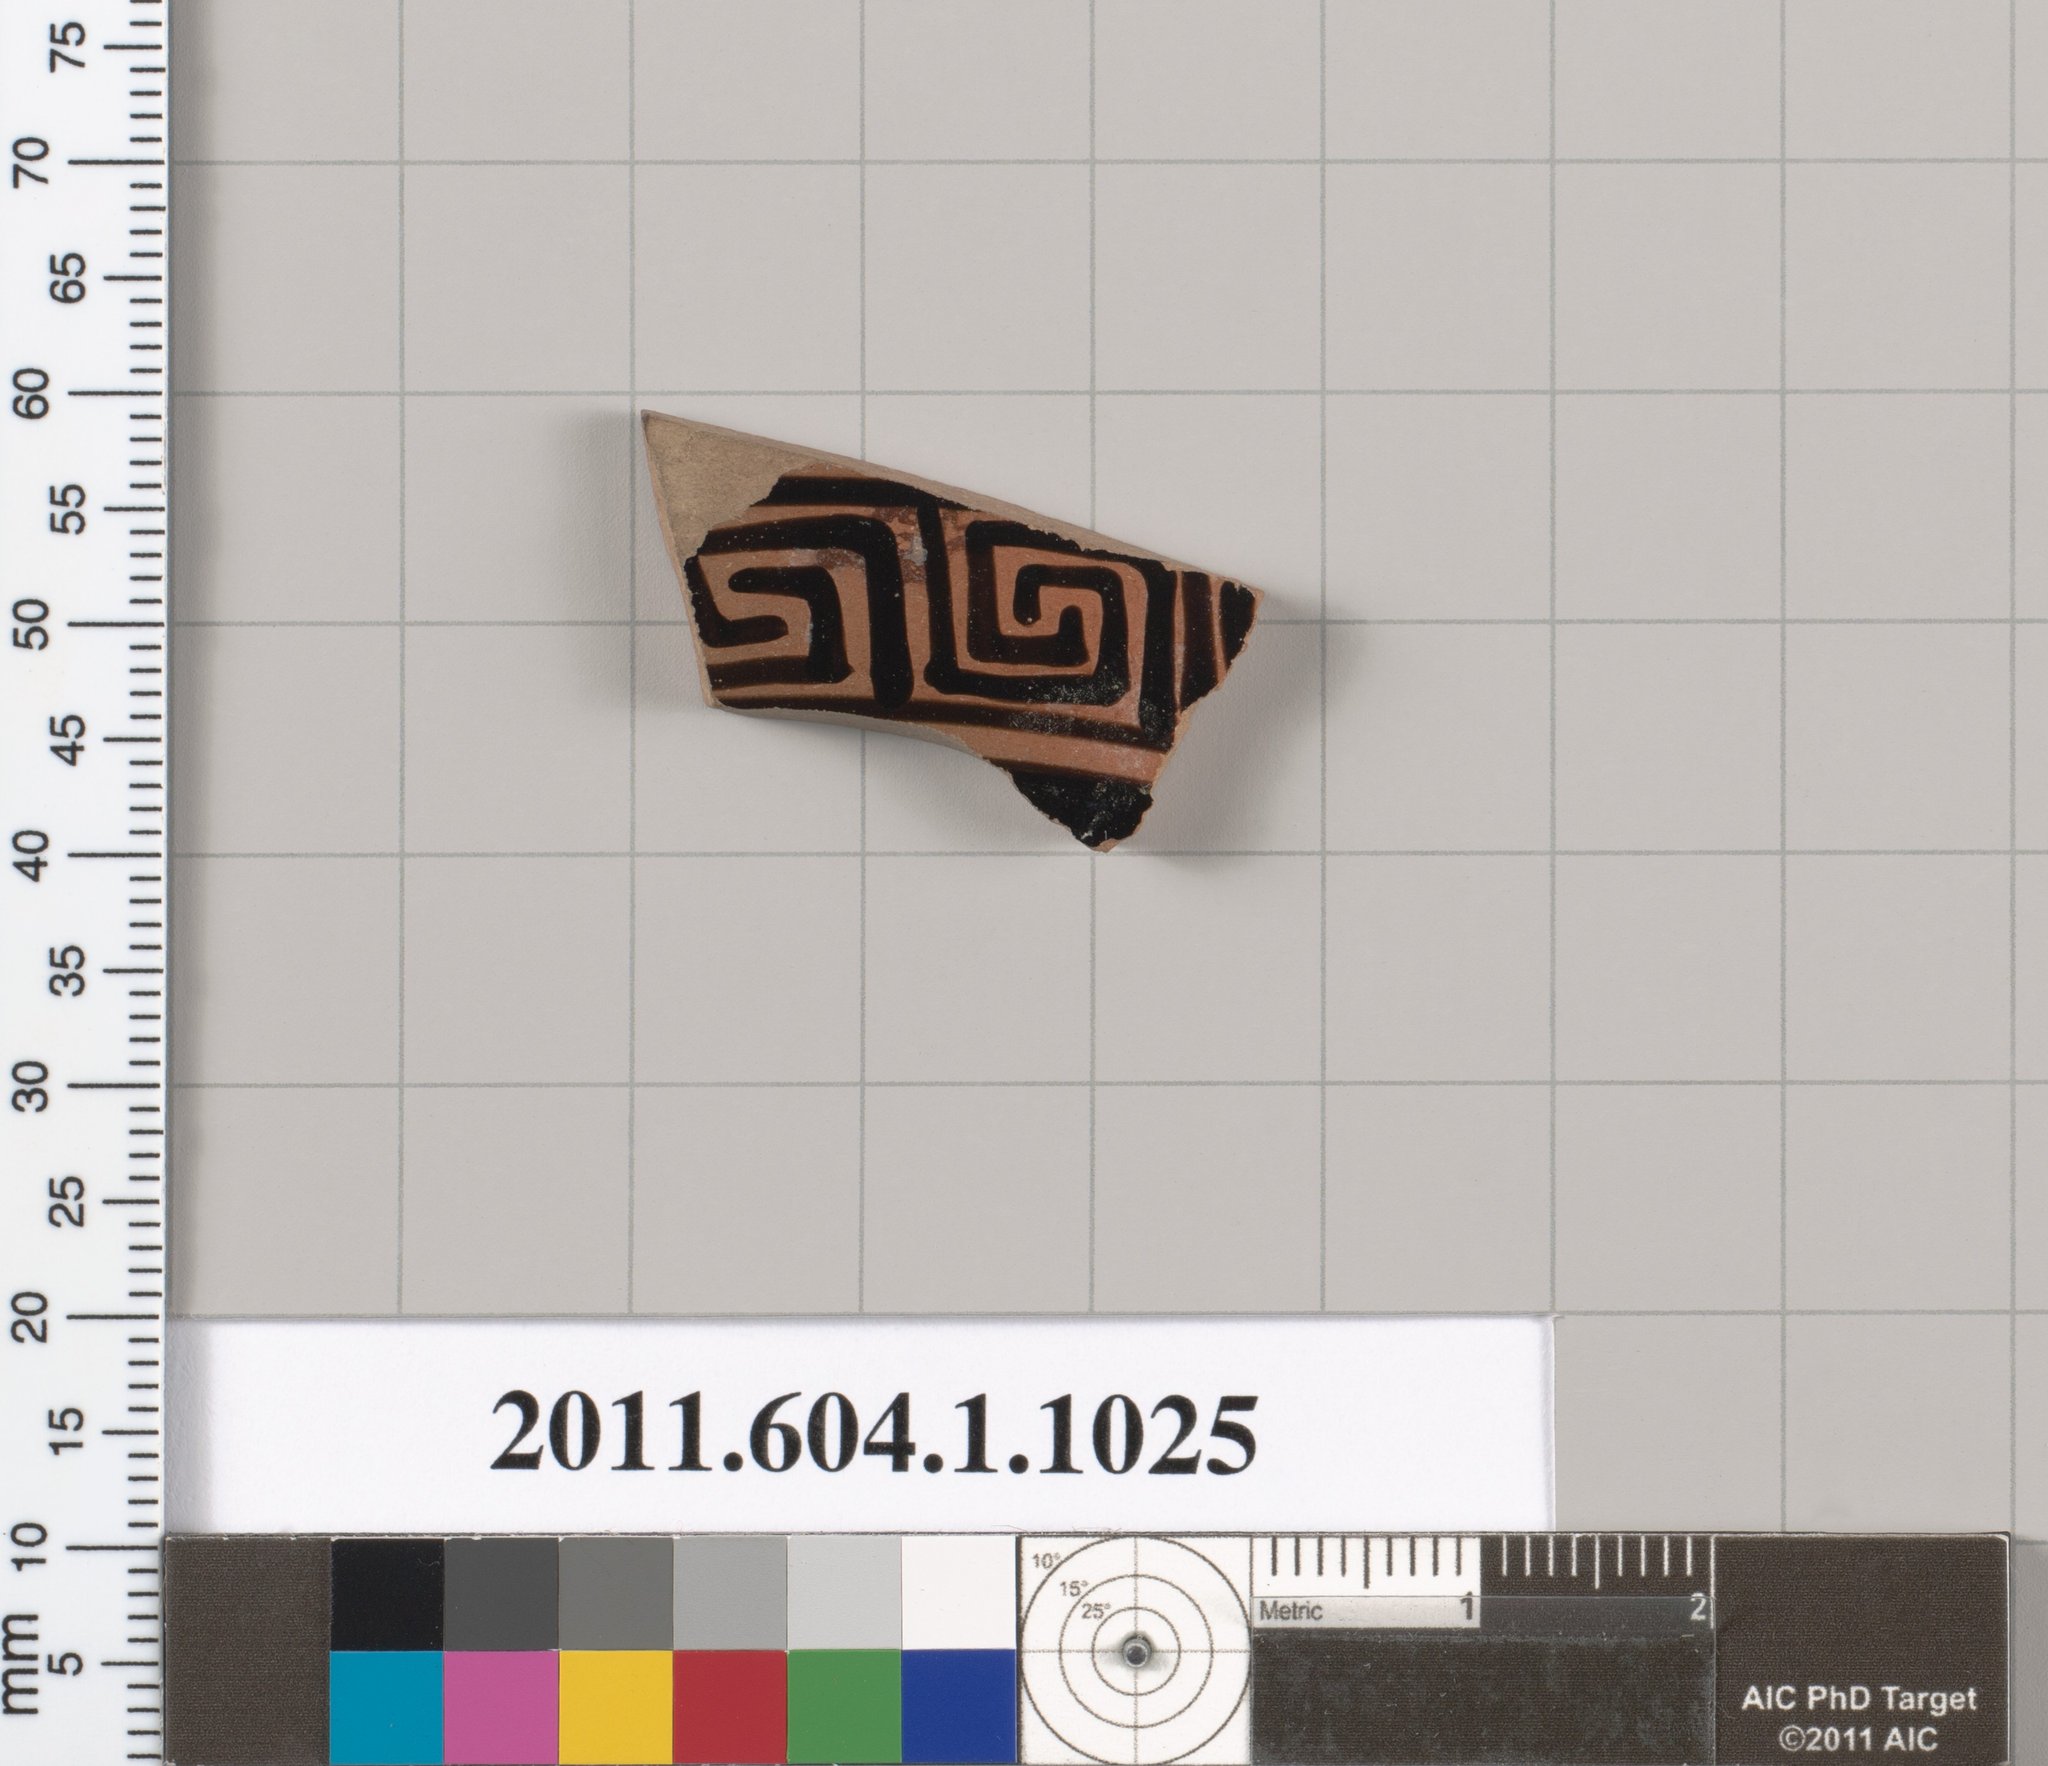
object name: kylix fragment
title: Terracotta fragment of a kylix (drinking cup)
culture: greek, attic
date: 500-476 BCE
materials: terracotta